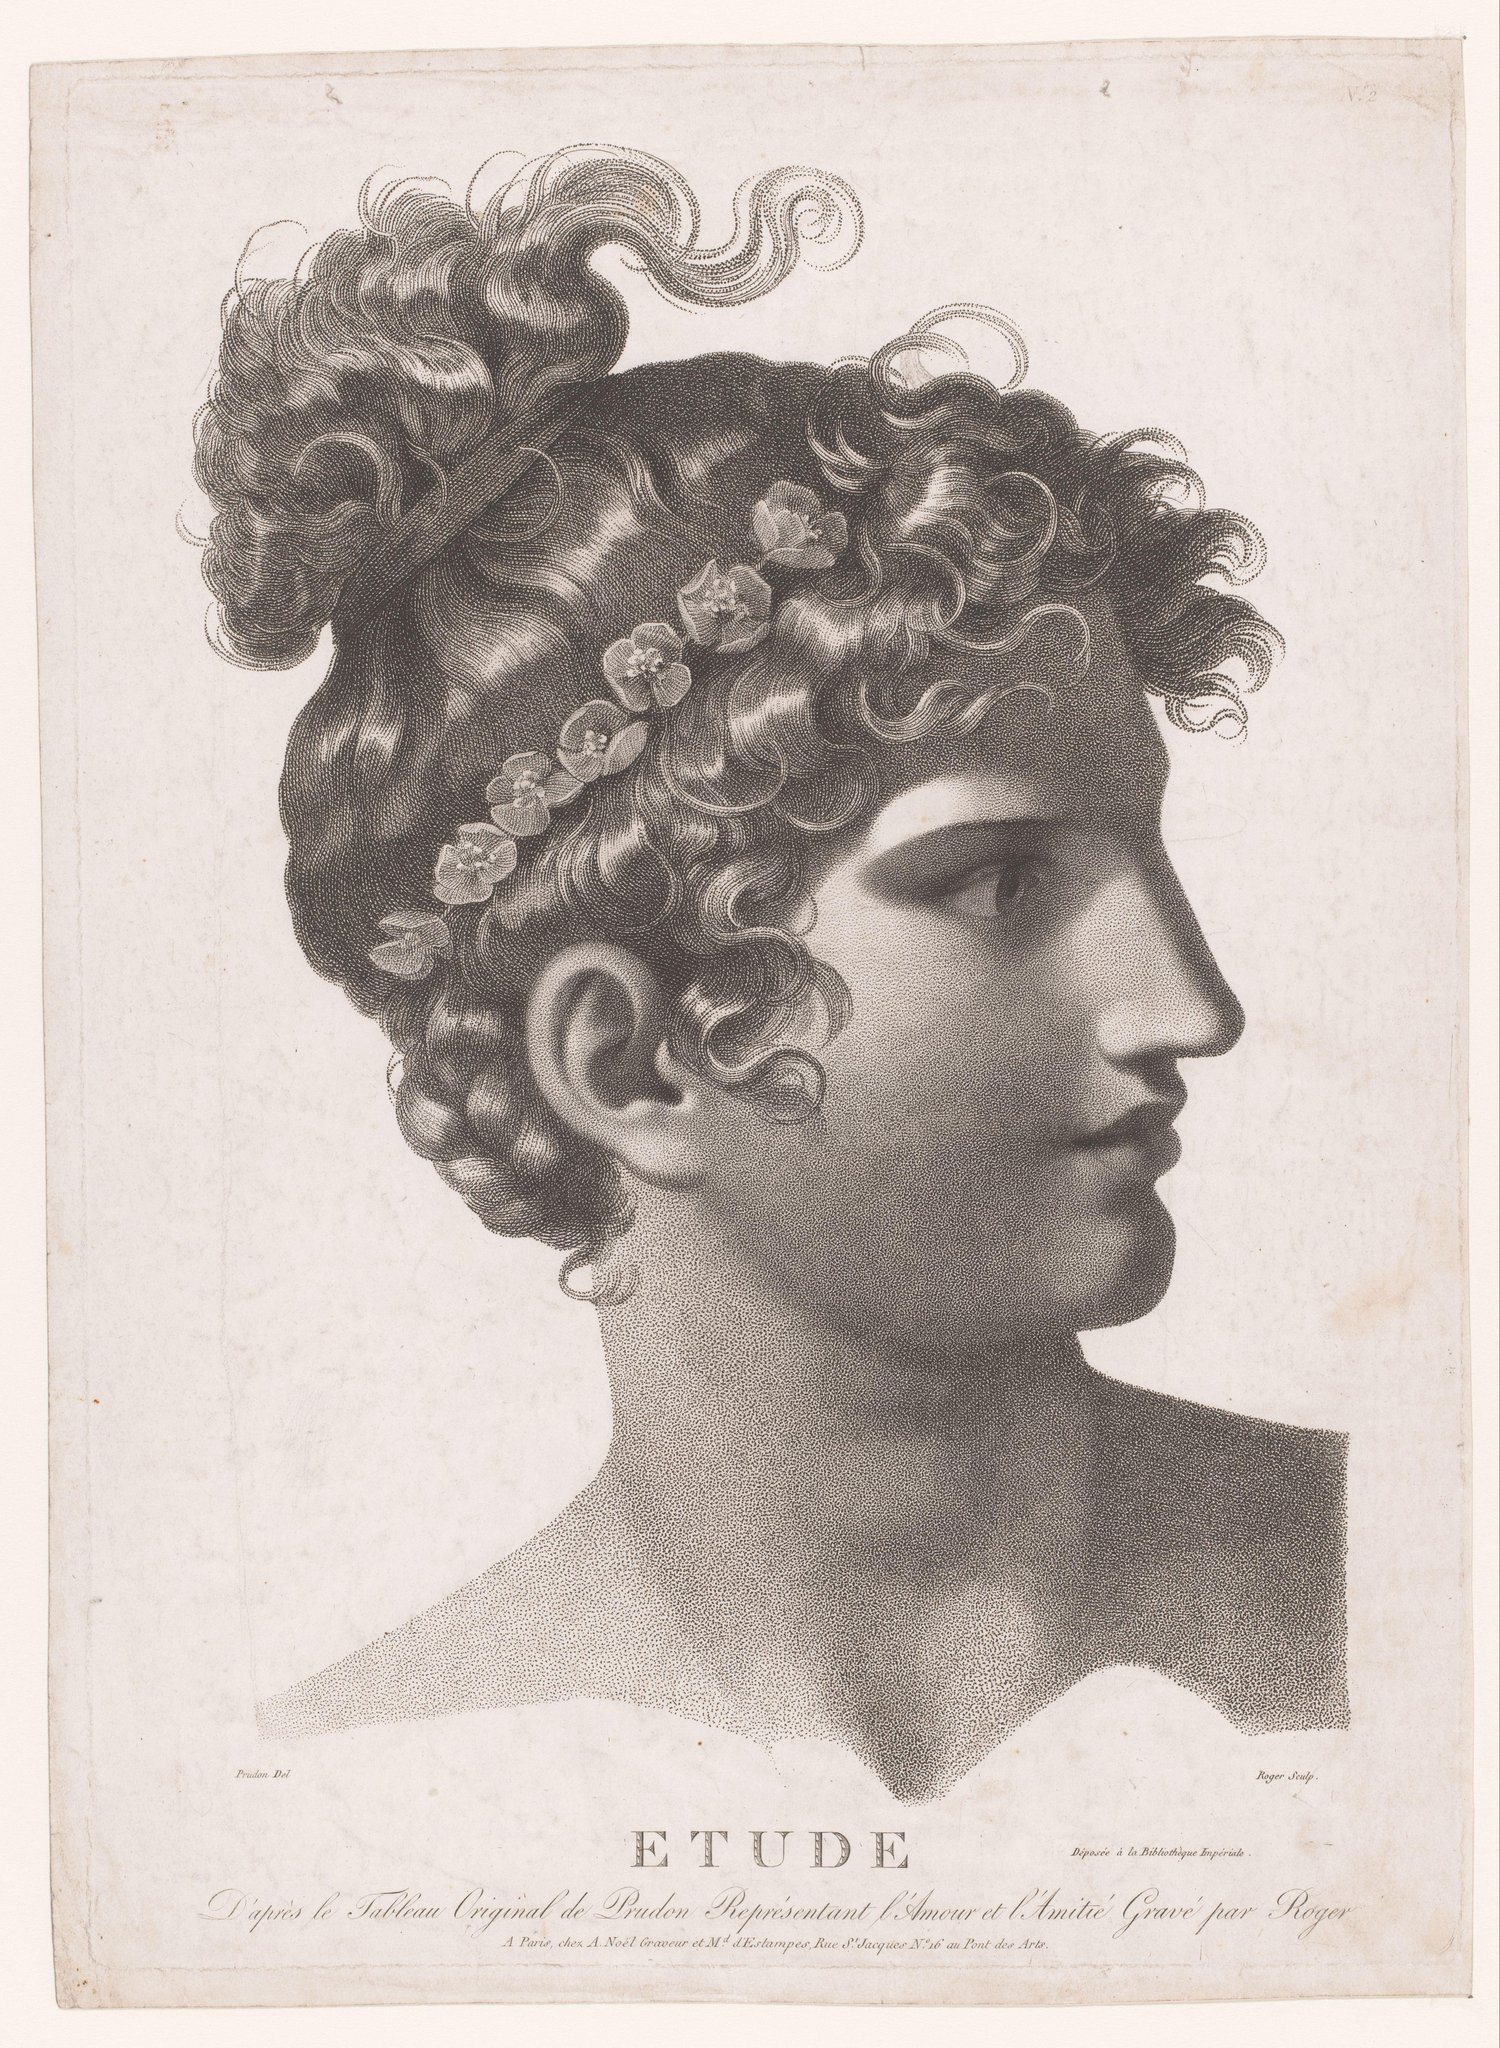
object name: print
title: Etude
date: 1777-1841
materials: paper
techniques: etching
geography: paris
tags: knowledge; 'cognitione', 'cognitione delle cose' (ripa), symbolic representations, allegories and emblems ~ education; 'ammaestramento', dottrina', 'educatione', 'istitutione' (ripa)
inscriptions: collector's mark: Lugt 2228, : ‘Déposé à la Bibliothèque Impériale’